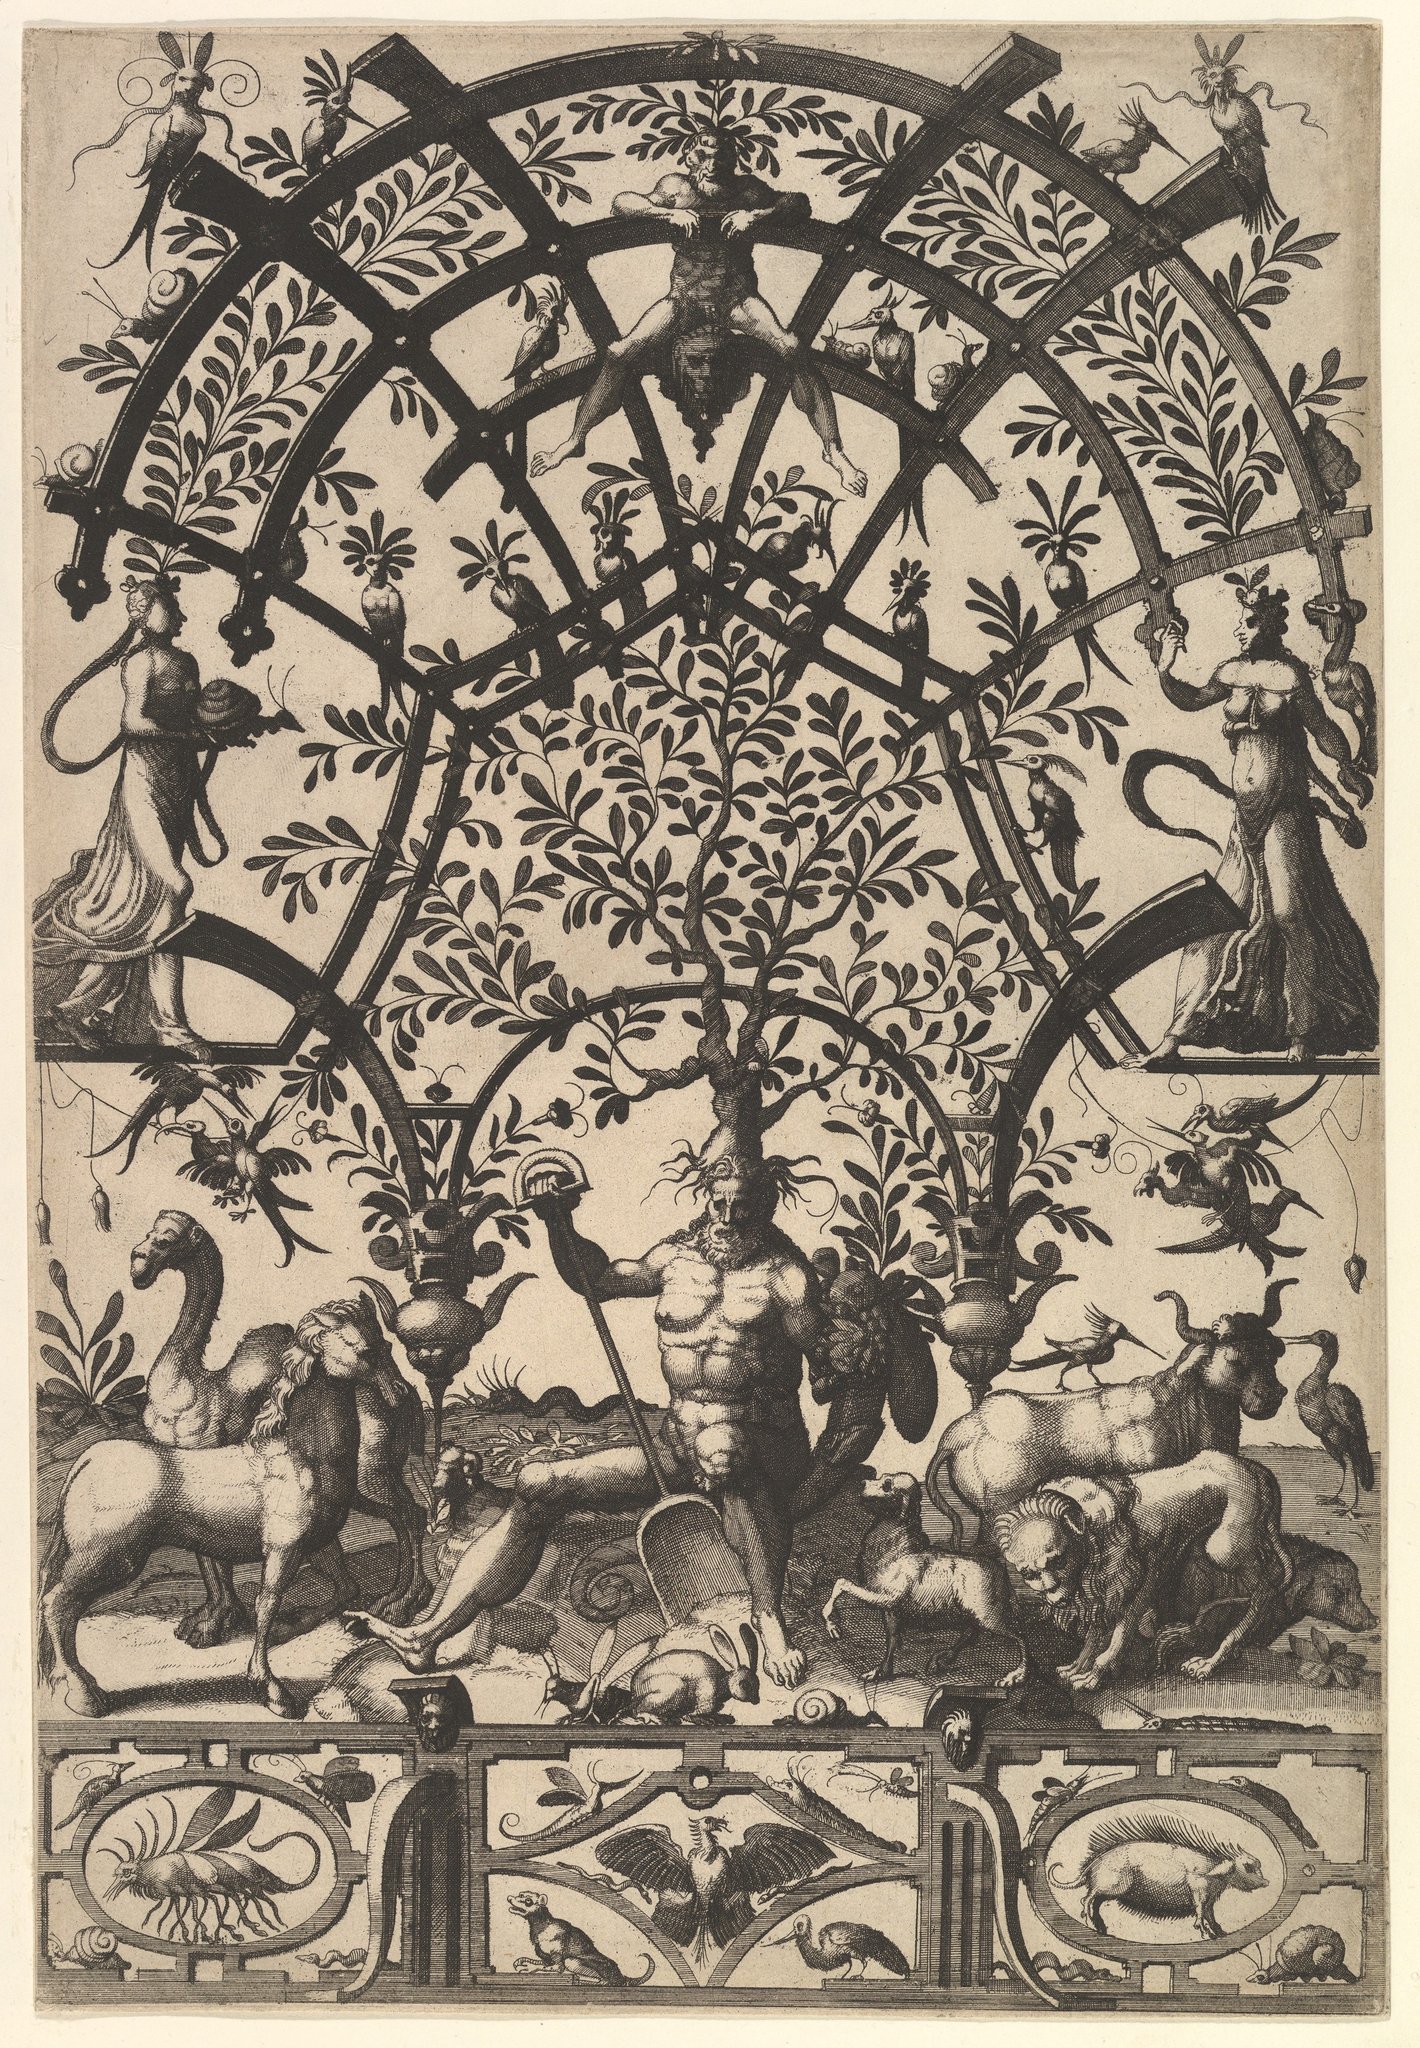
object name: book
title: Personification of Earth, with Spade and Horn, Supporting a Tree and Lattice on His Head, A Frieze underneath from Veelderleij niewe inventien van antijckesche sepultueren diemen nou zeere ghebruijkende is met noch zeer fraeije grotissen en compertimenten zeer beqwame voer beeltsniders antijcksniders schilders en all constenaers...Libro Secundo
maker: johannes van doetecum i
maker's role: artist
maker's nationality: netherlandish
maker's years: 1528-1605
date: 1557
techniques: engraving, etching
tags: animals,male nudes,trees